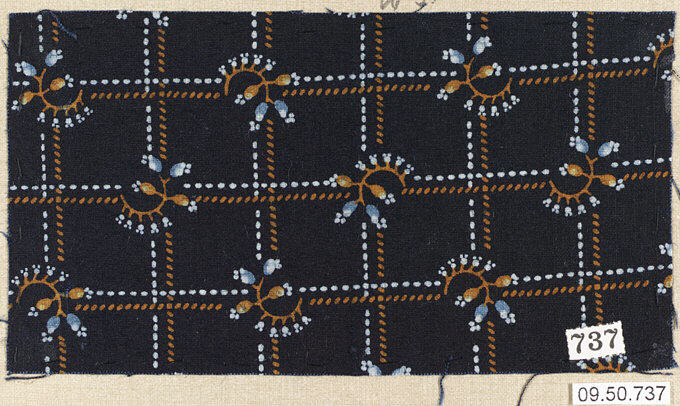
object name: piece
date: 1801-1900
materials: cotton